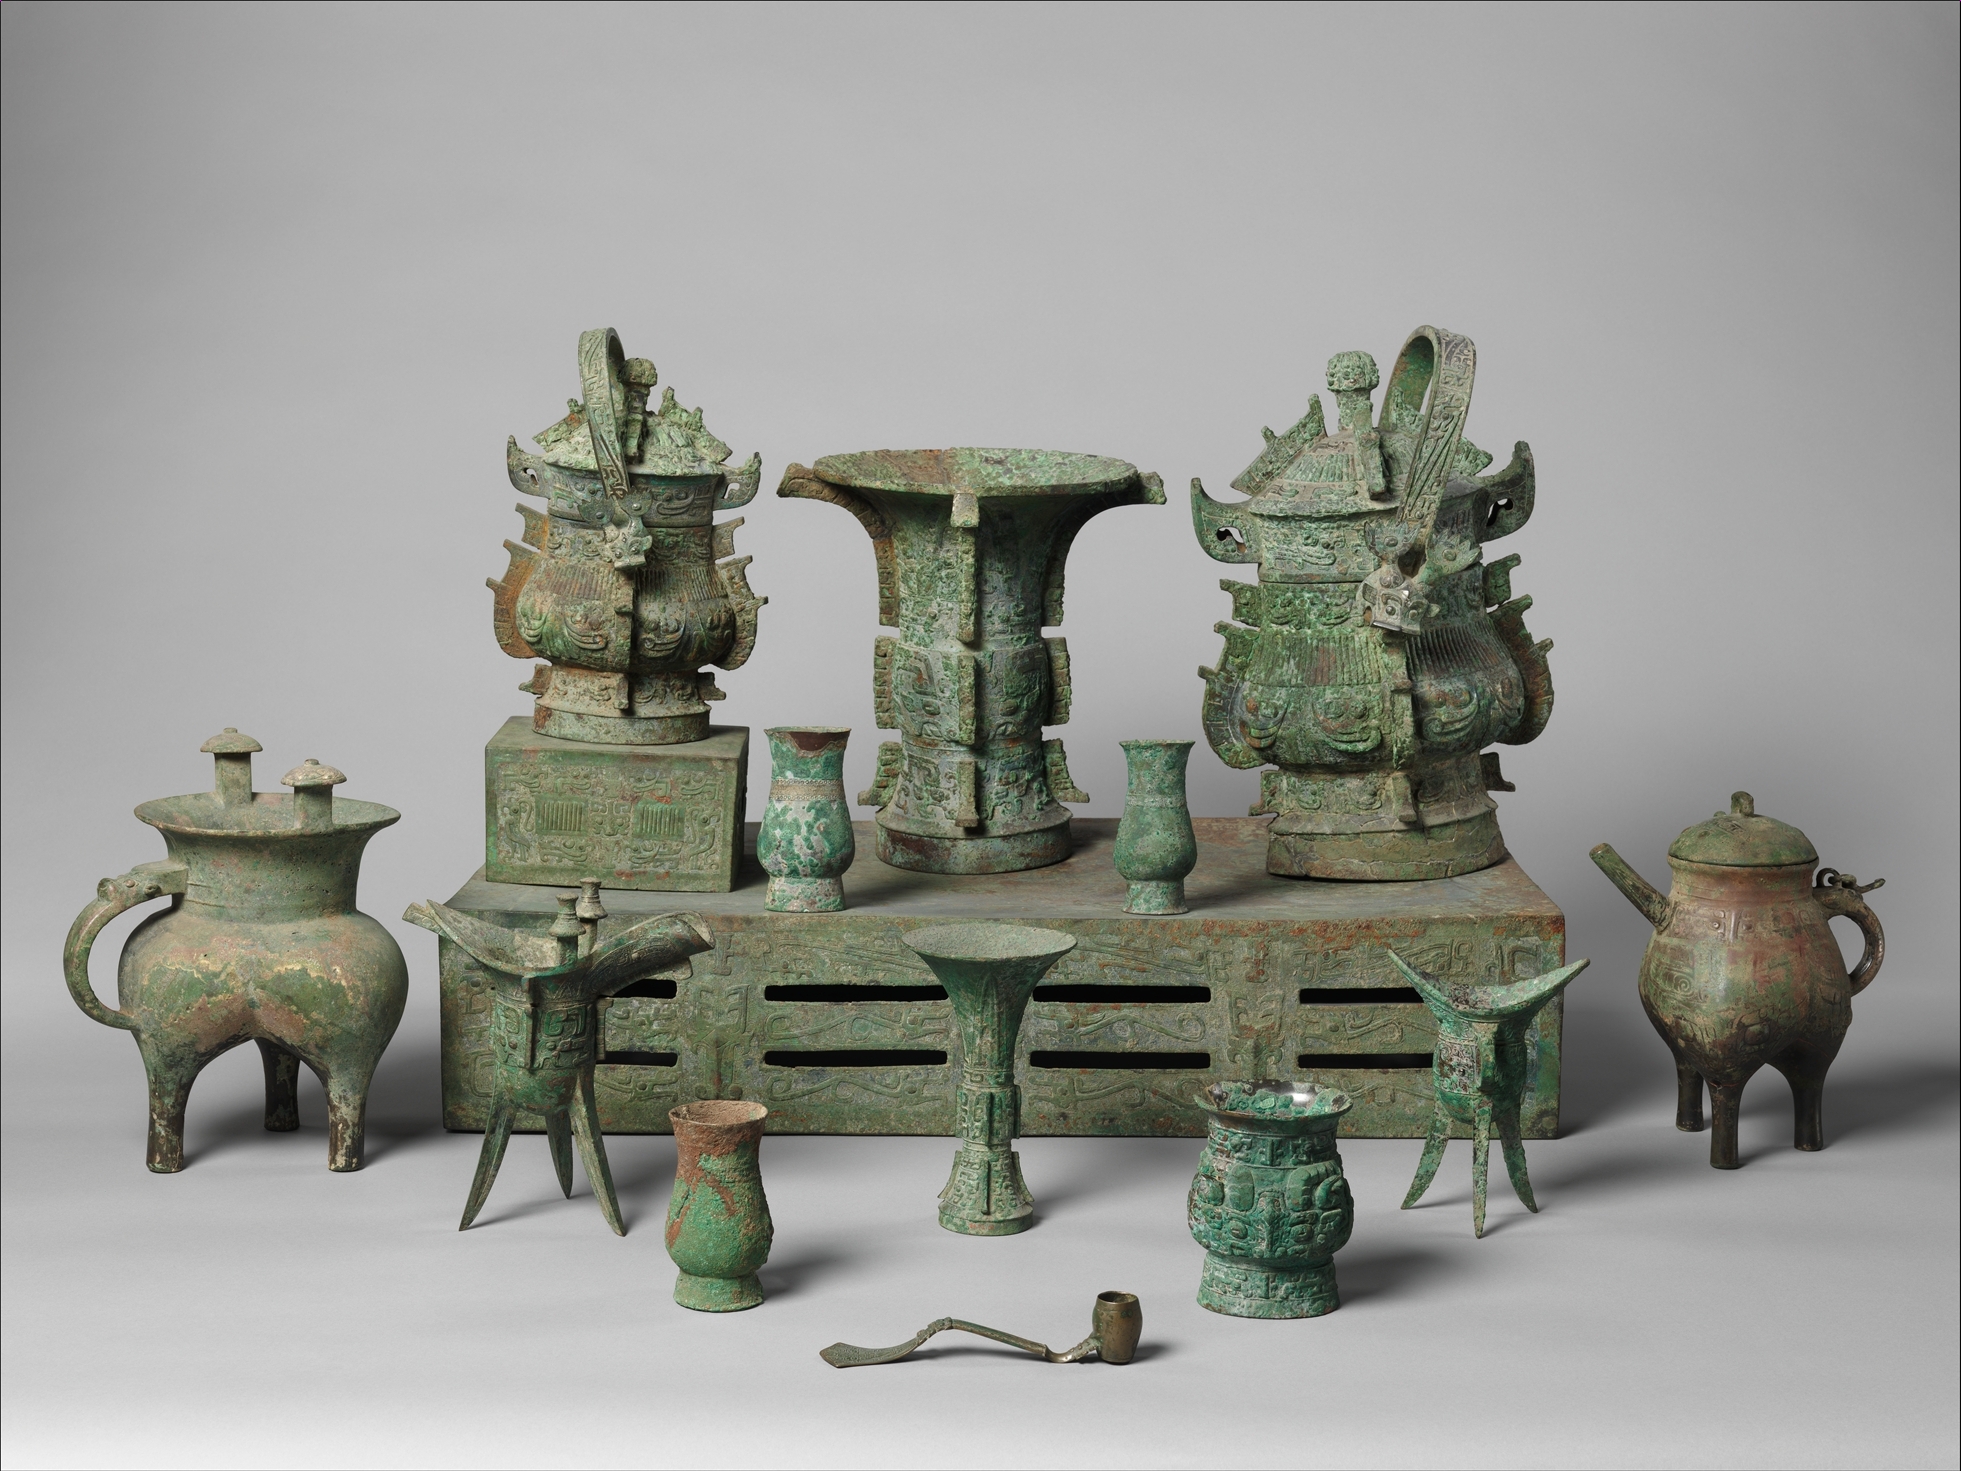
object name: altar set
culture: chinese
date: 1034-1001 BCE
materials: bronze